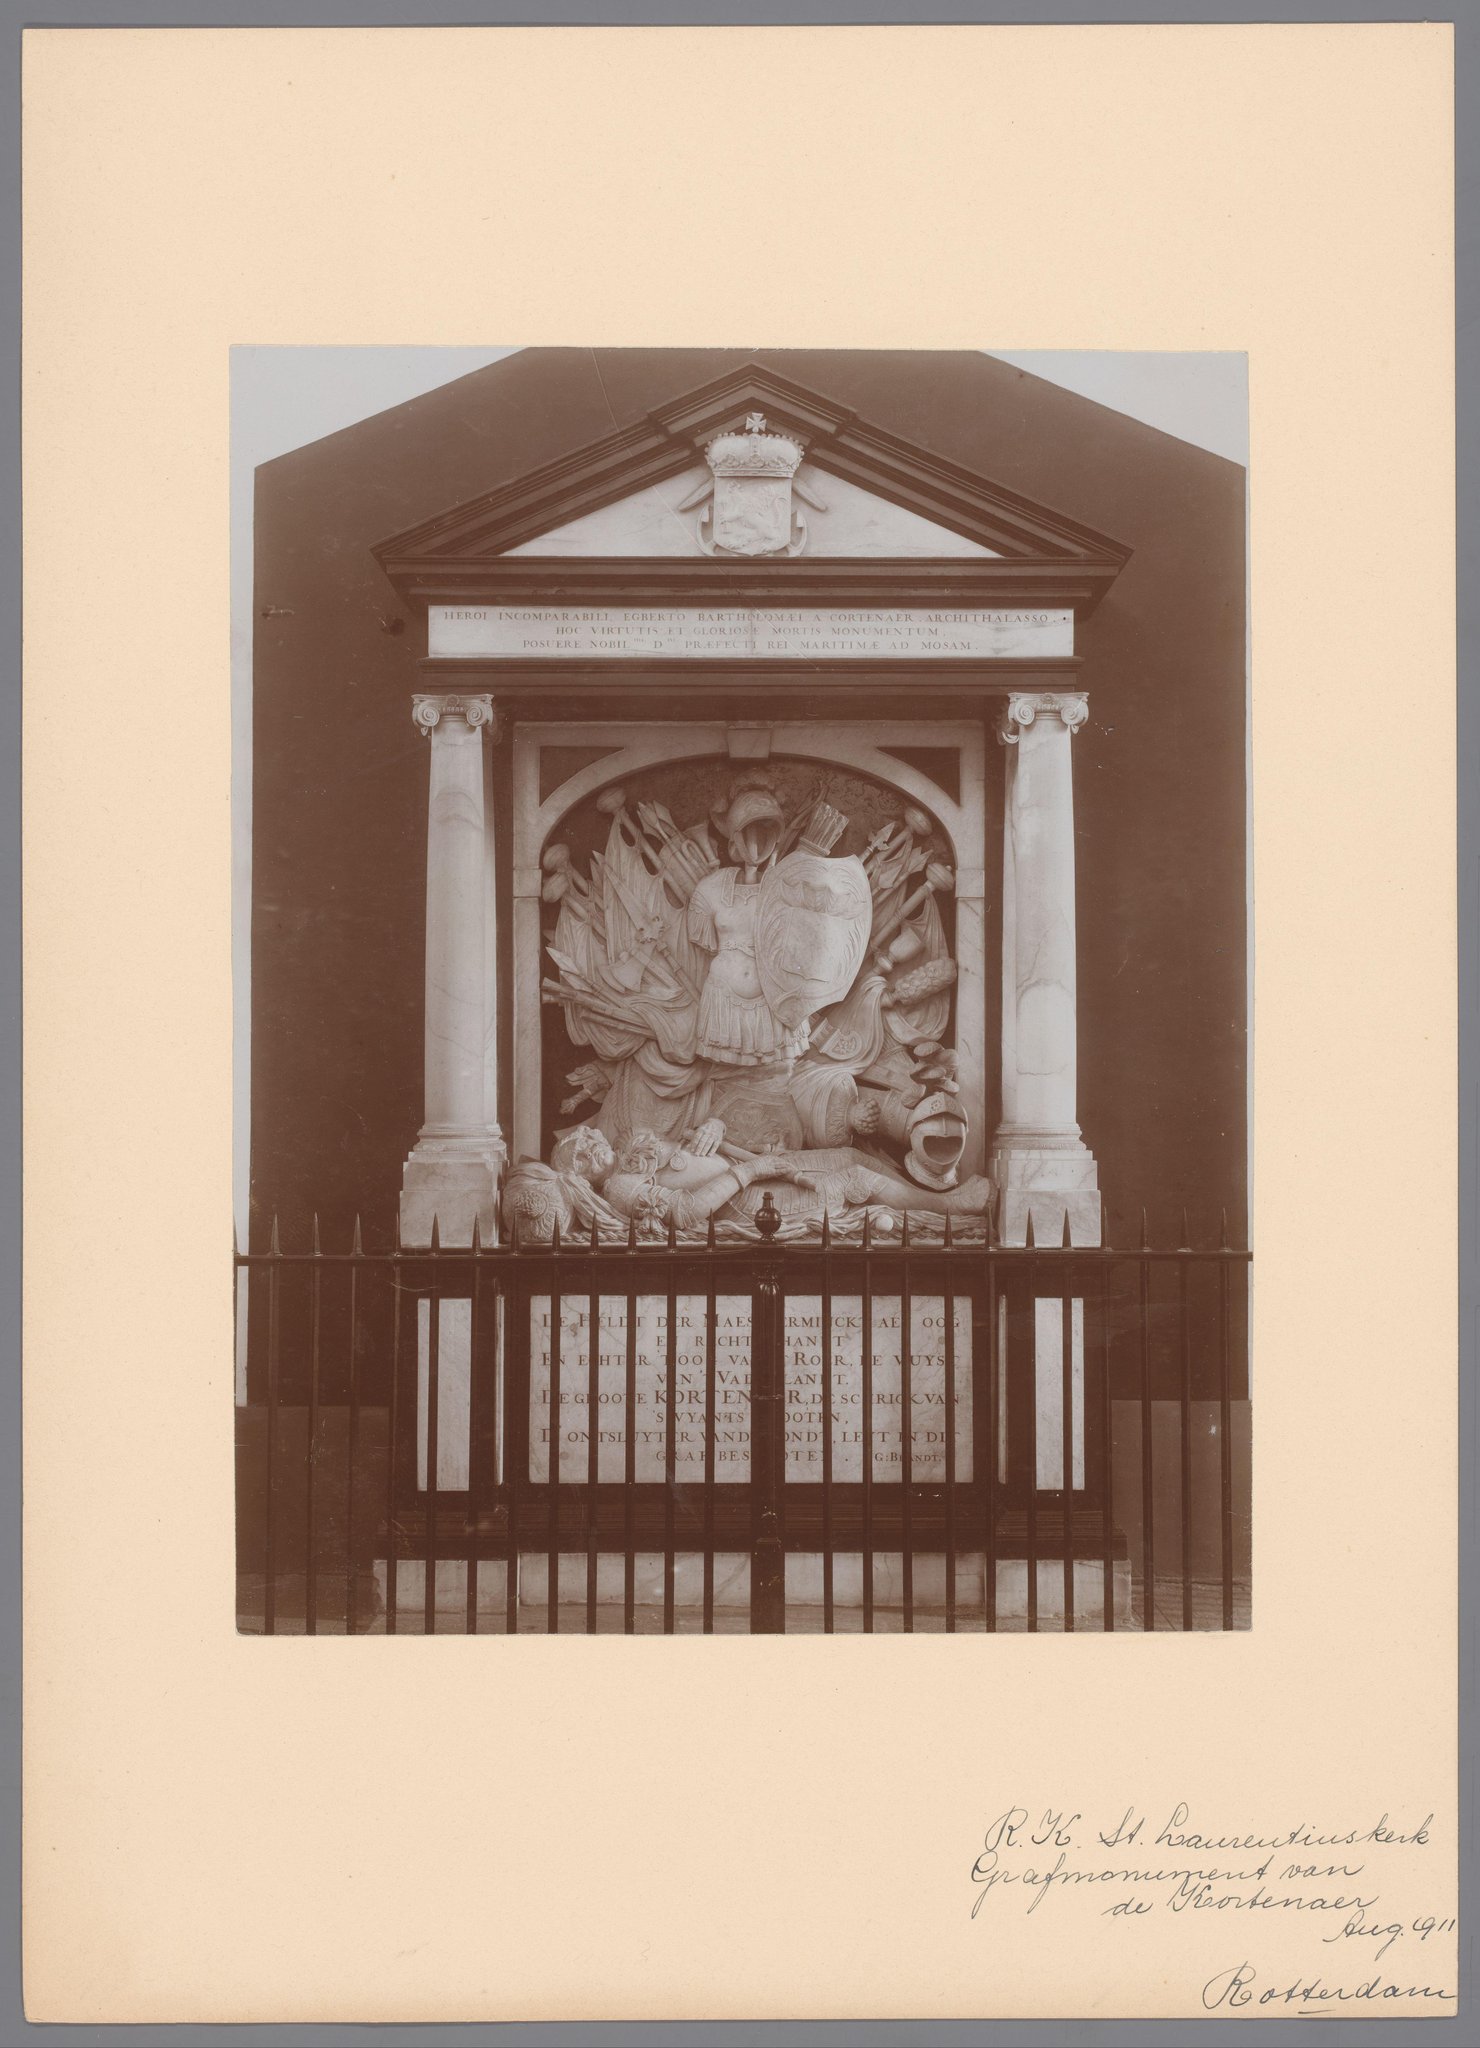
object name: photograph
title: Grafmonument van Egbert Meeusz Kortenaer in de Grote of Sint-Laurenskerk te Rotterdam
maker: anoniem (monumentenzorg)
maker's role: fotograaf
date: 1911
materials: cardboard, photographic support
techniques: collodion silver print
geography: grote of sint-laurenskerk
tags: interior of church, grave-building, monumental tomb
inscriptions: annotation: ‘R.K. St. Laurentiuskerk/ Grafmonument van de Kortenaer/ Aug. 1911/ Rotterdam’, annotation: ‘J.C. Ludeman/ 1685-1757’, collector's mark: ‘R.MUS.’